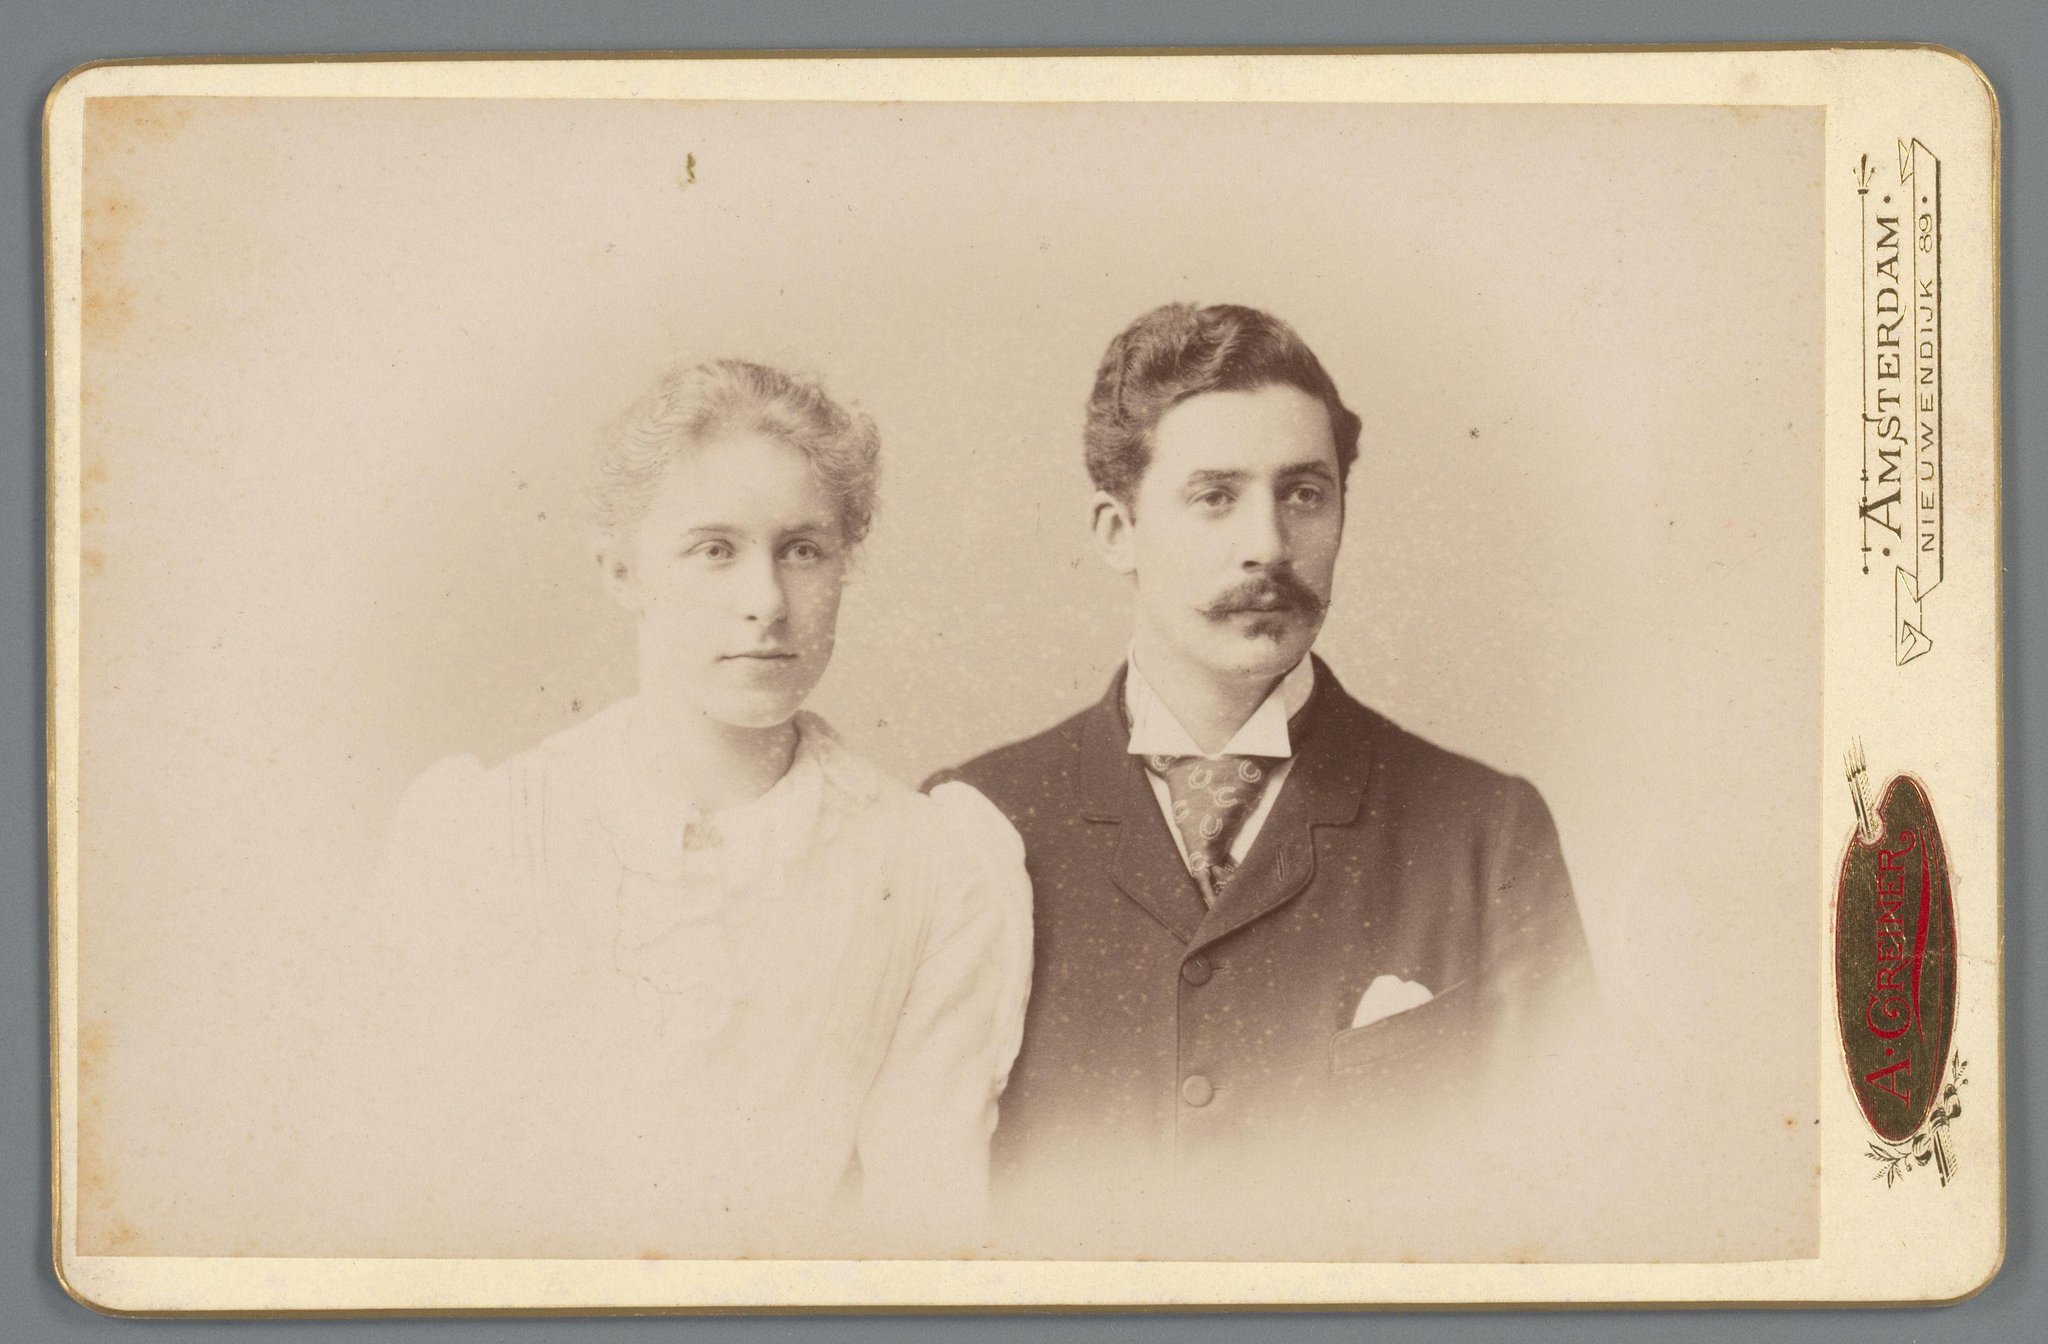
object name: cabinet photograph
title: Portret van een onbekende man en vrouw, mogelijk leden van de familie Onnen-van den Berg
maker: albert greiner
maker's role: fotograaf, fotostudio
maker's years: 1833-1890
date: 1883-1887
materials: cardboard, paper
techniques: albumen print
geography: amsterdam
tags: anonymous historical persons portrayed in a double portrait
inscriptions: address: ‘Amsterdam/ NIEUWENDIJK 89.’, inscription: ‘Van vriend Wellington/ van 14-16 April 1890/ + vriend Furnie [?] van Leden [?]/ Jan. 1891./ [...]’